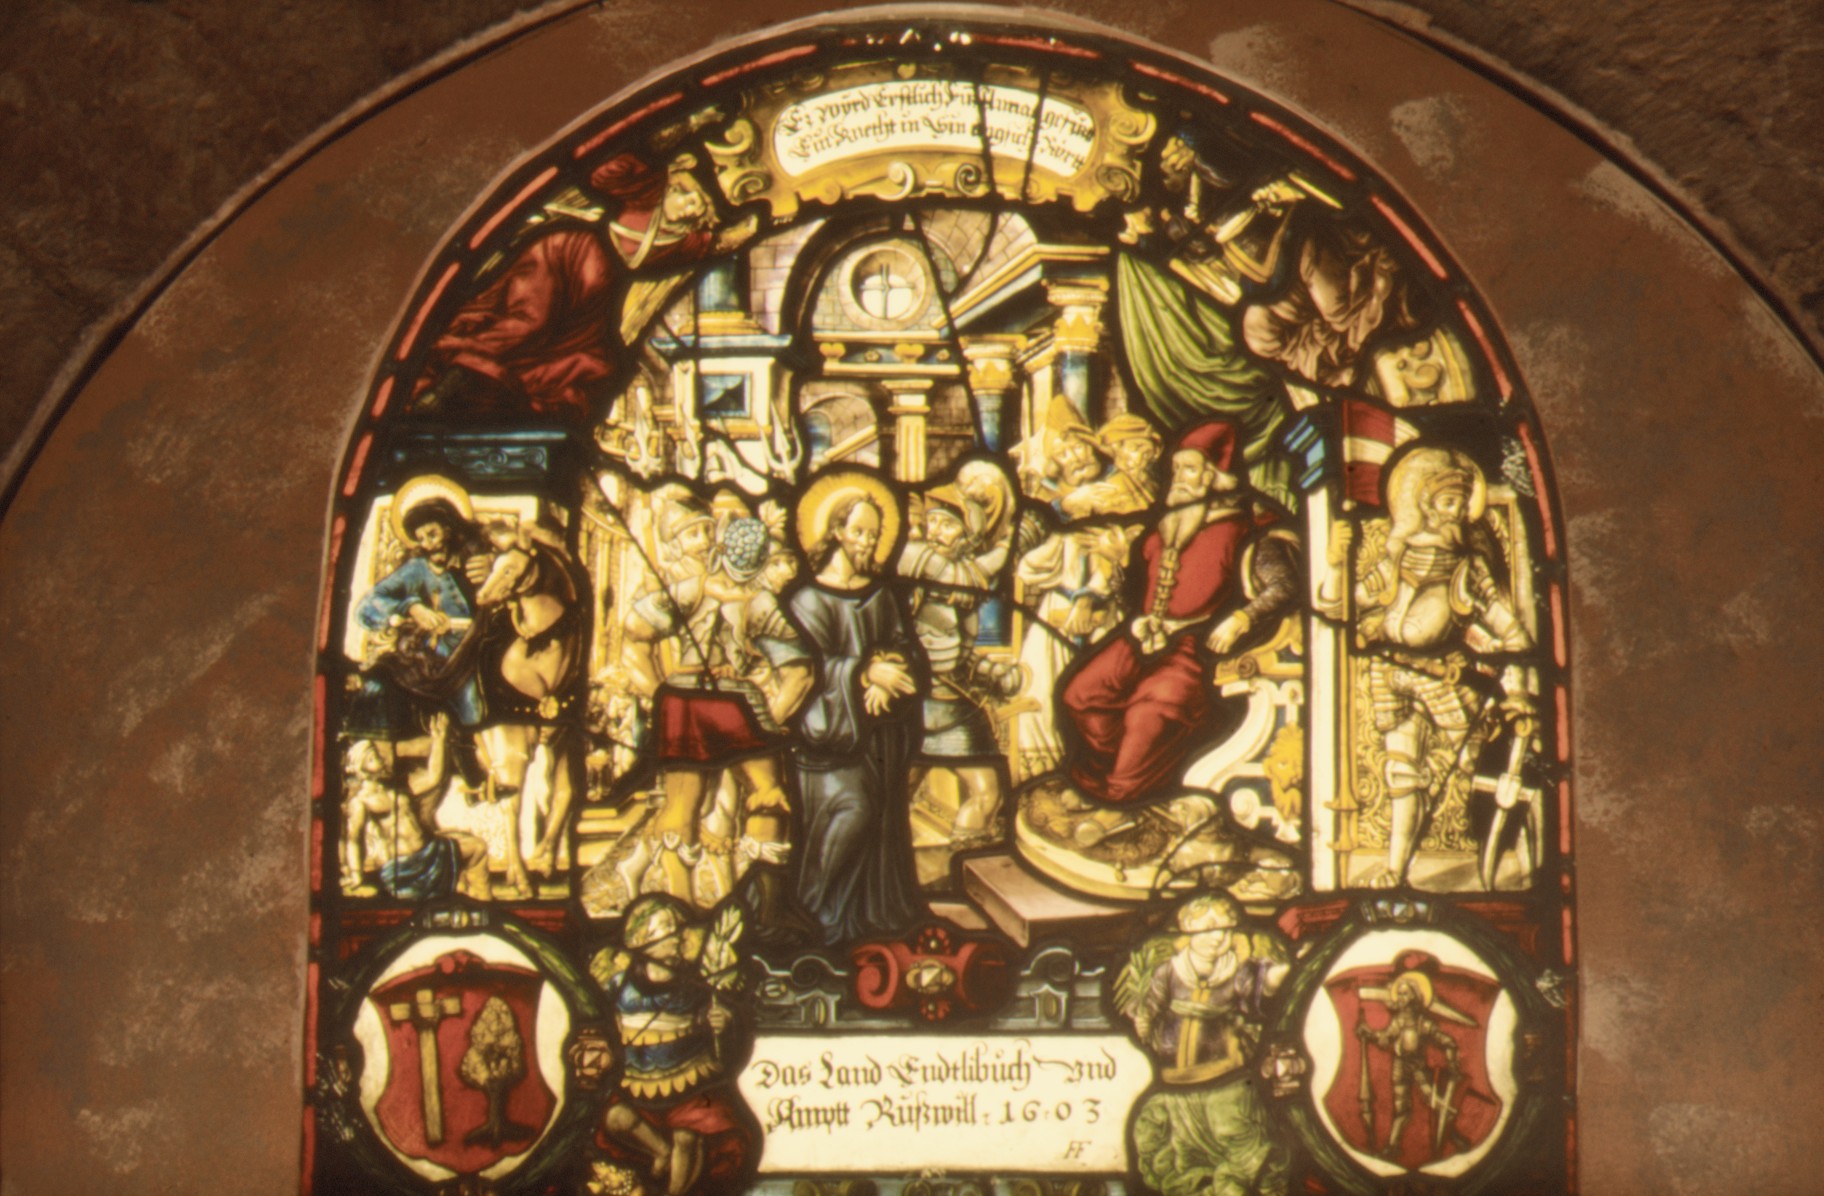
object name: panel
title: Christ Before Annas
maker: franz fallenter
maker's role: artist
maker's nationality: german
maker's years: 1550-1616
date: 1603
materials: glass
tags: soldiers,christ,saints